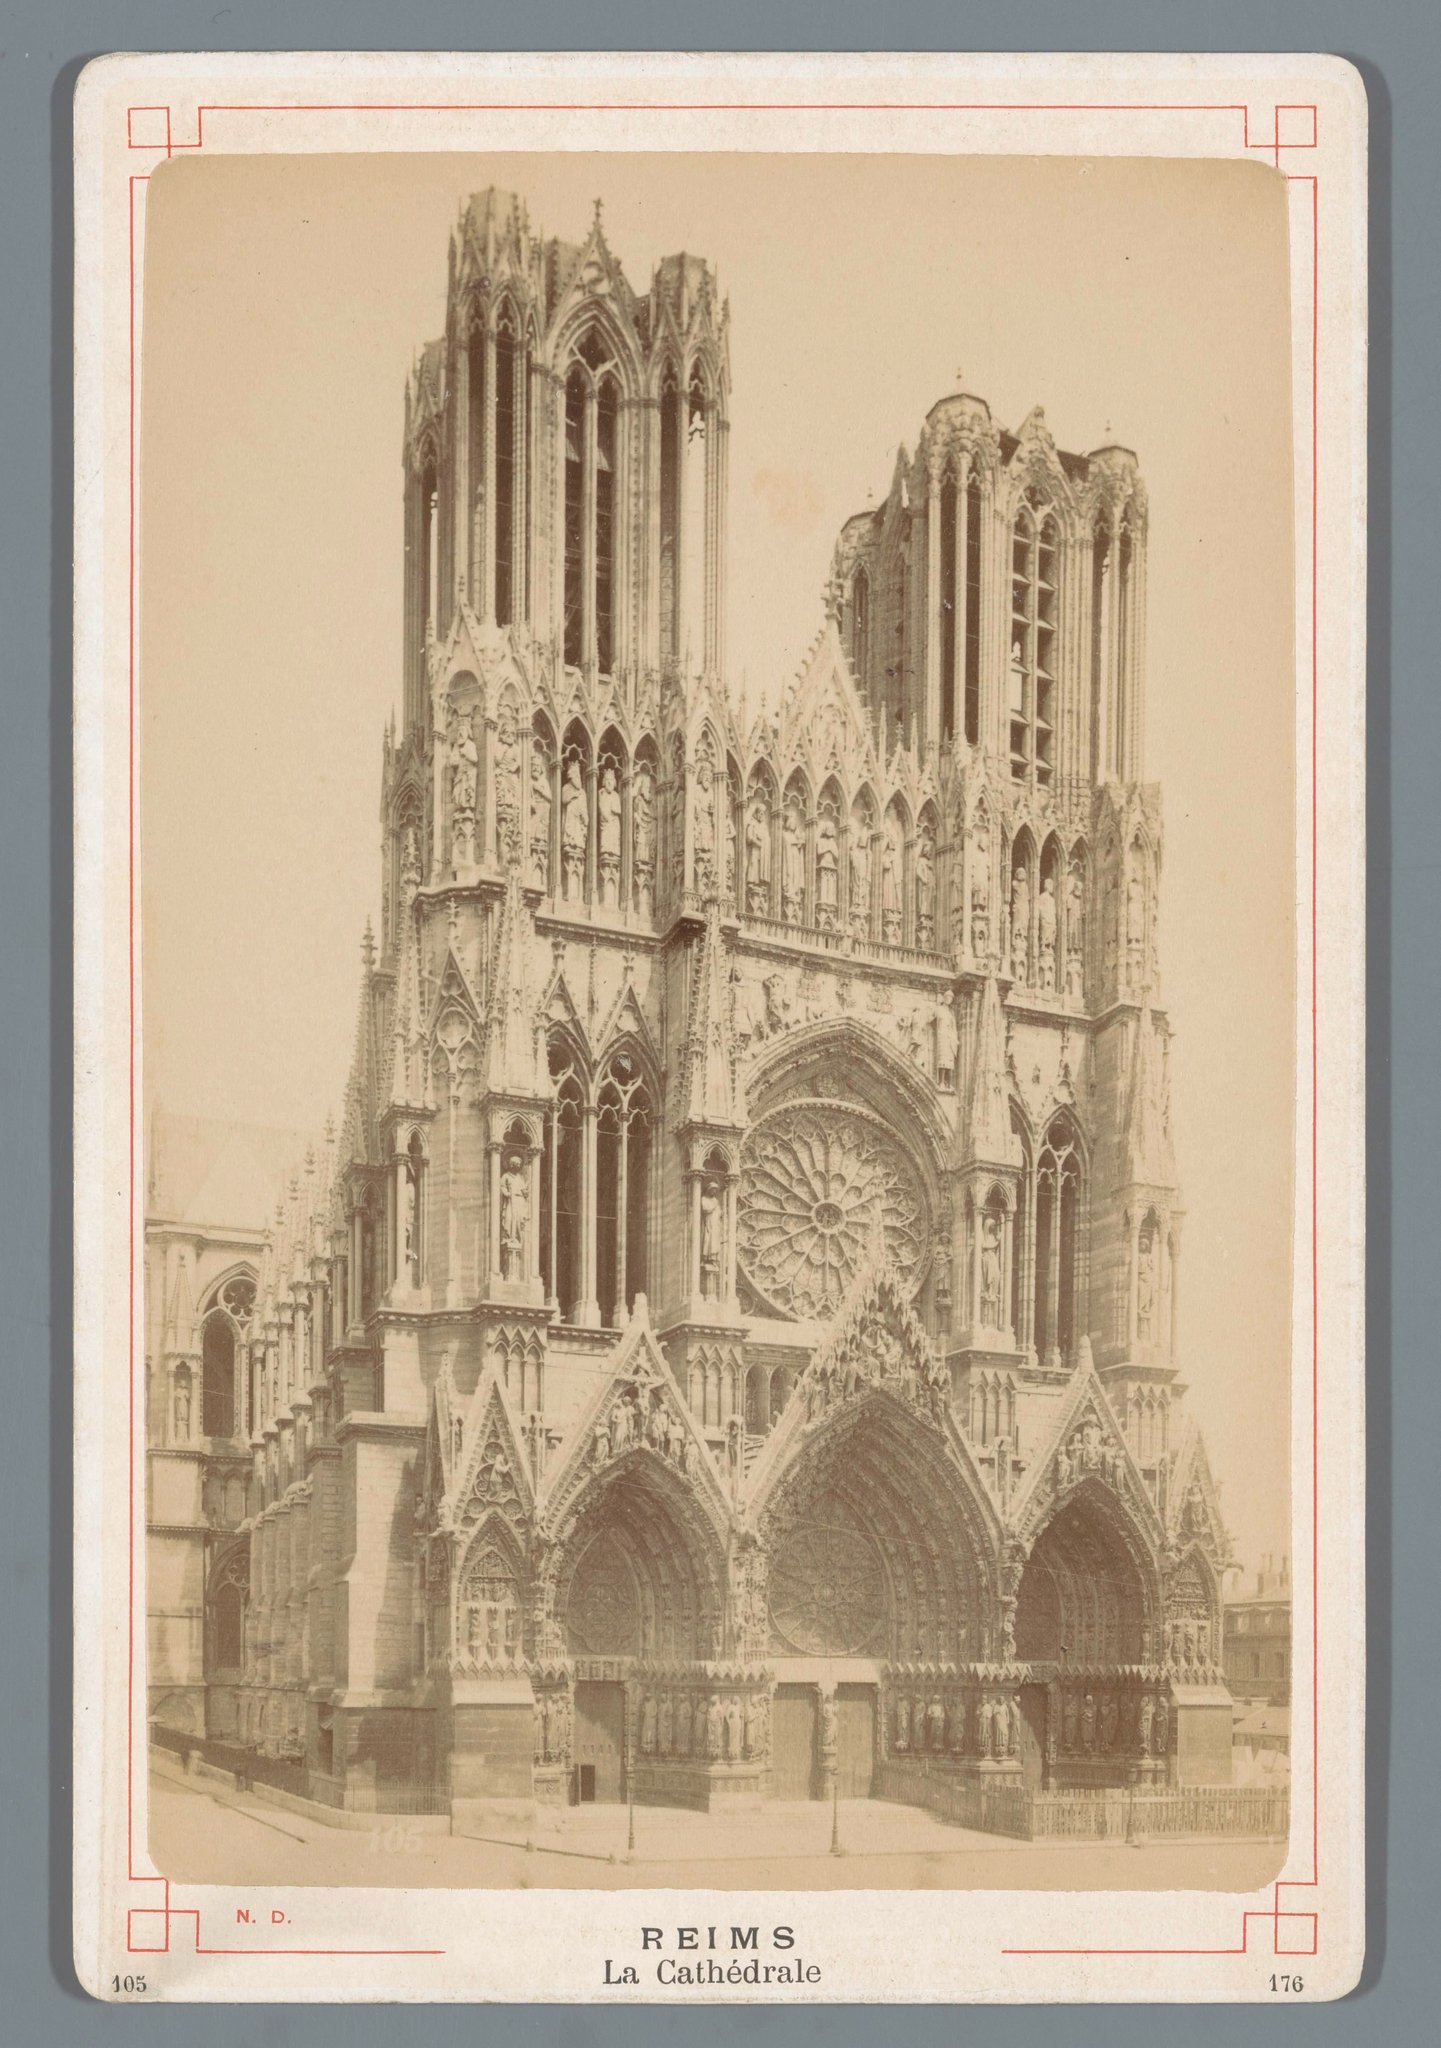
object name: photograph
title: La Cathédrale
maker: étienne neurdein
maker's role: publisher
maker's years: 1832-1918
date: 1870-1900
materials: cardboard, photographic support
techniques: albumen print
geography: reims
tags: church (exterior), façade (of house or building)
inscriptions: number: ‘105’, initials: ‘N.D.’, retailer's mark: ‘librairie, papeterie, eliure/ Th. WARME/ REIMS/ 2, Pl. du Palais de Justice’, annotation: ‘fig.’, number: ‘105/ 176’